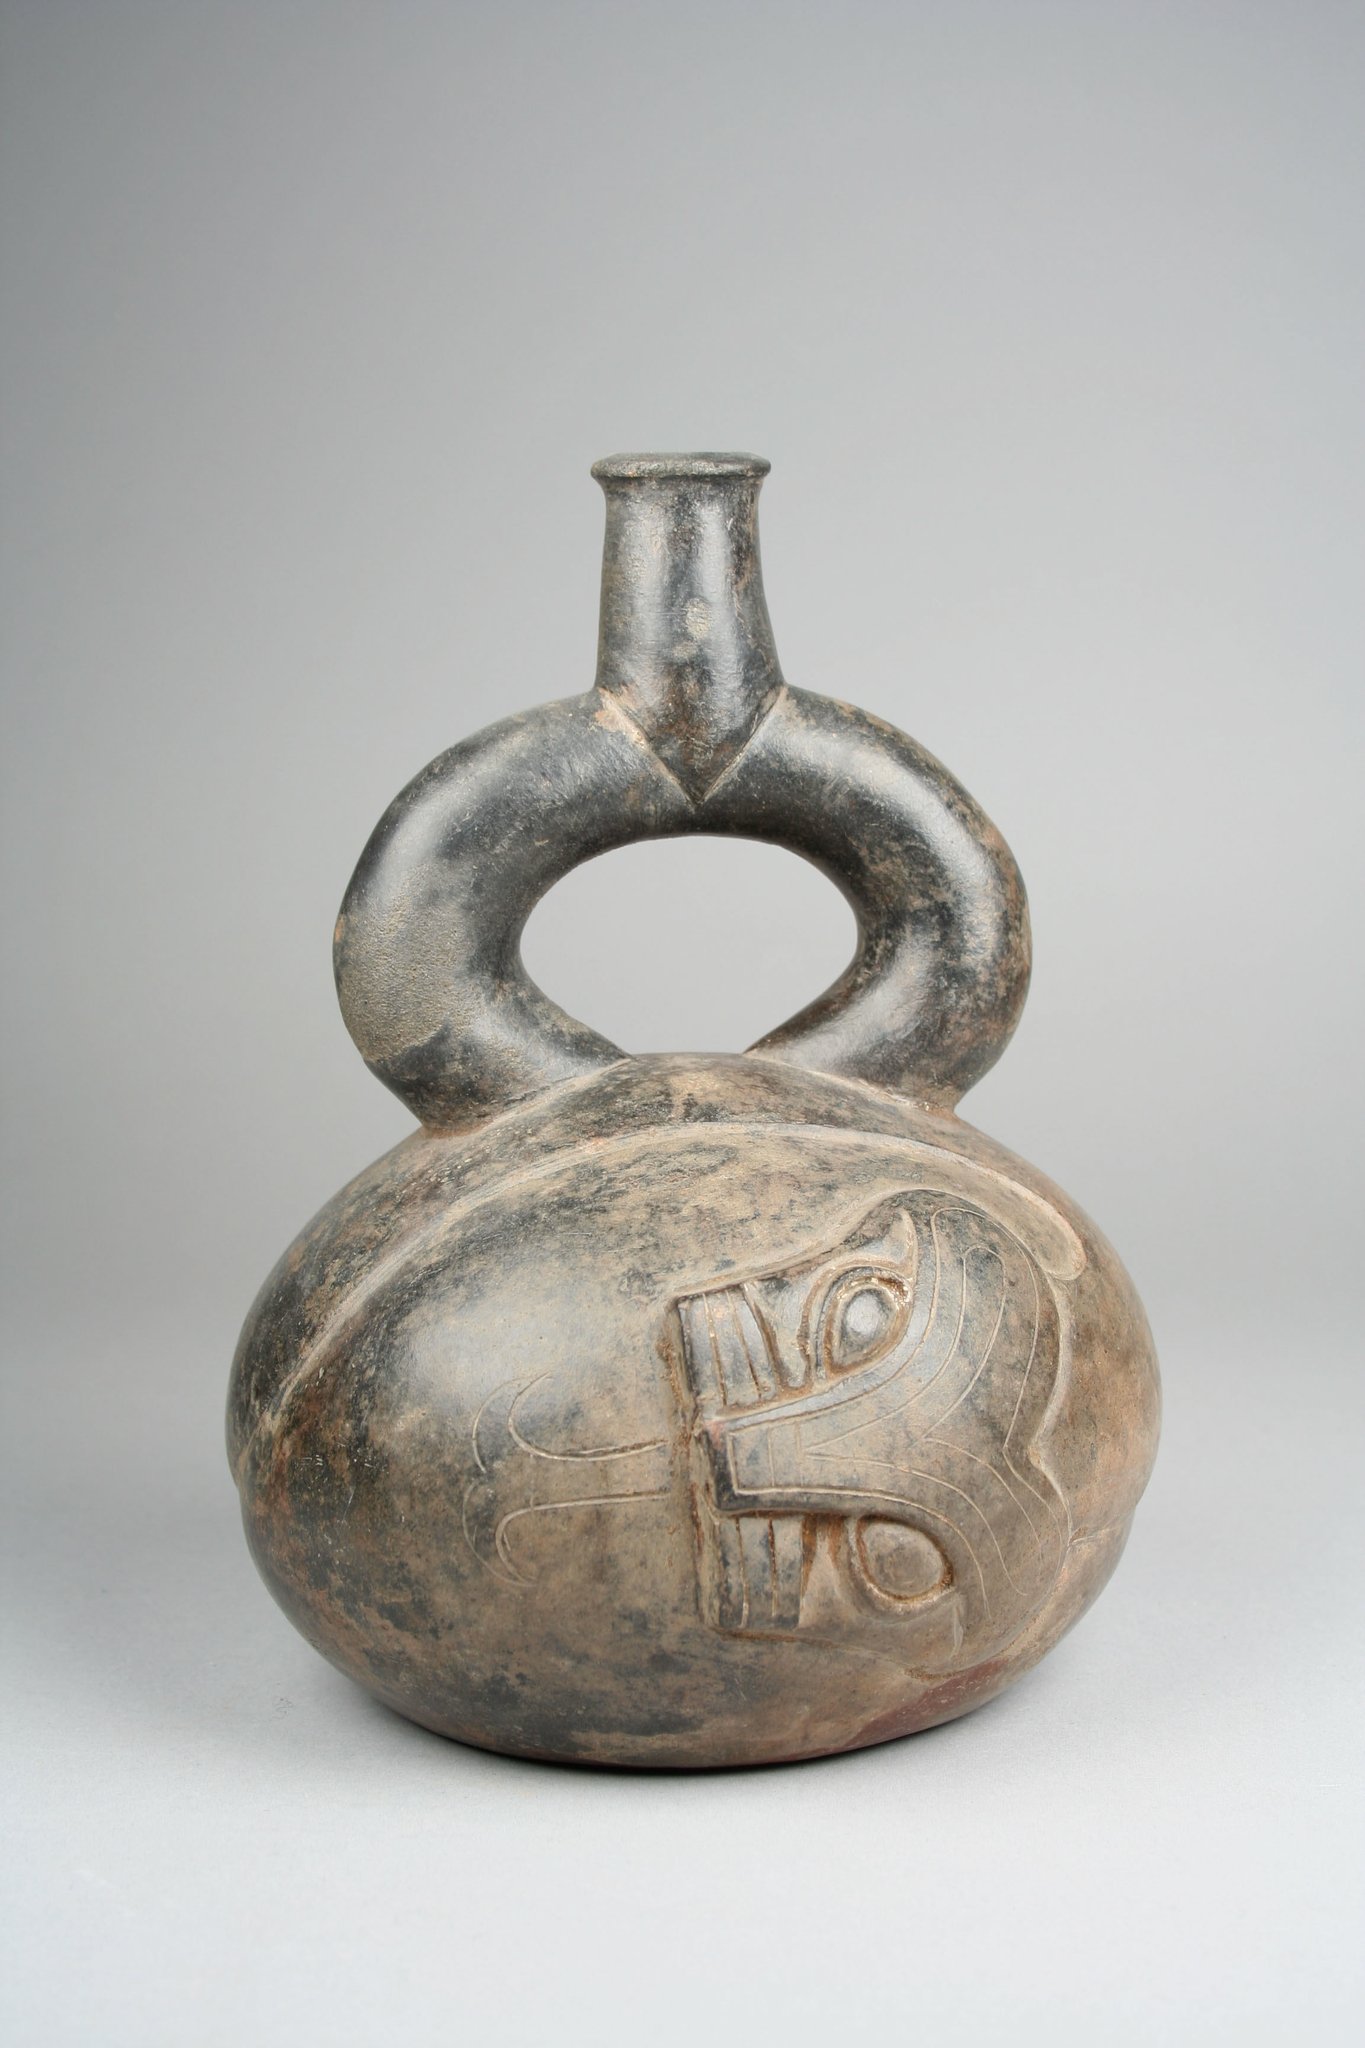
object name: bottle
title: Stirrup Spout Bottle with Serpent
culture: moche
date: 100 BCE-700 CE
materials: ceramic, pigment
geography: peru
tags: serpents